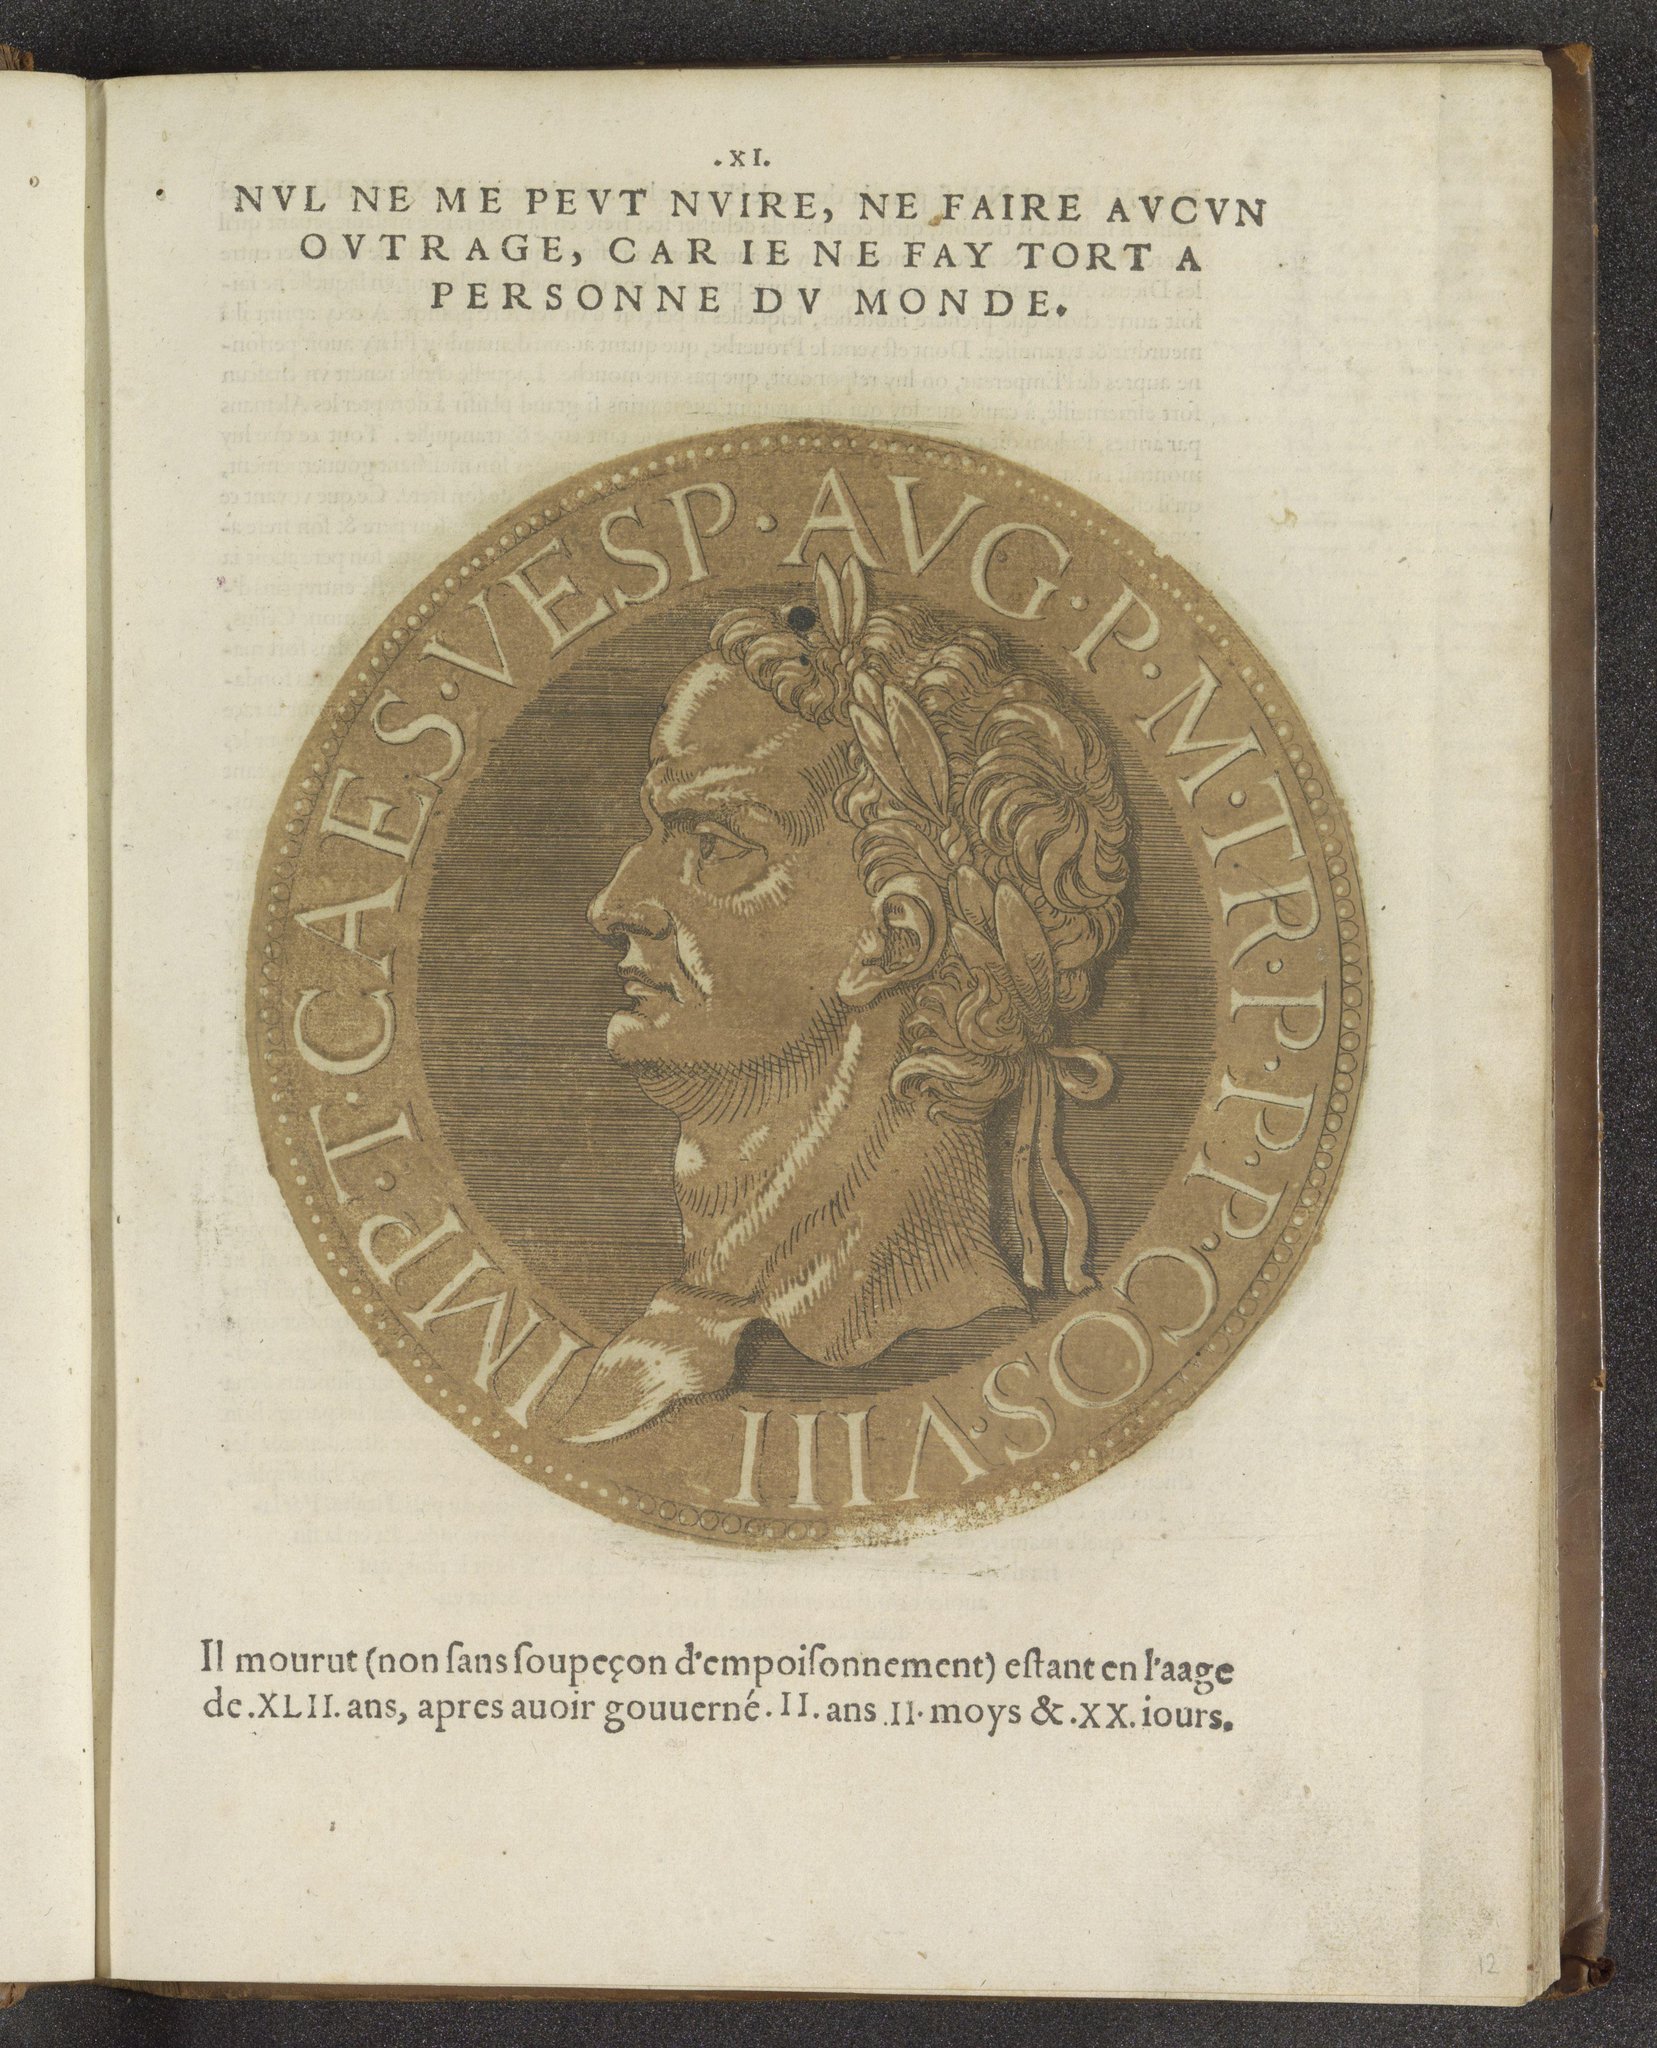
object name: print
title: Les images presque de tous les empereurs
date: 1557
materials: paper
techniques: woodcut, etching, letterpress printing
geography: antwerp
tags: rome, emperor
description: Portret van keizer Titus, op een munt met randschrift. De prent maakt deel uit van een boek over de keizers vanaf Julius Caesar tot en met Karel V en zijn broer Ferdinand.